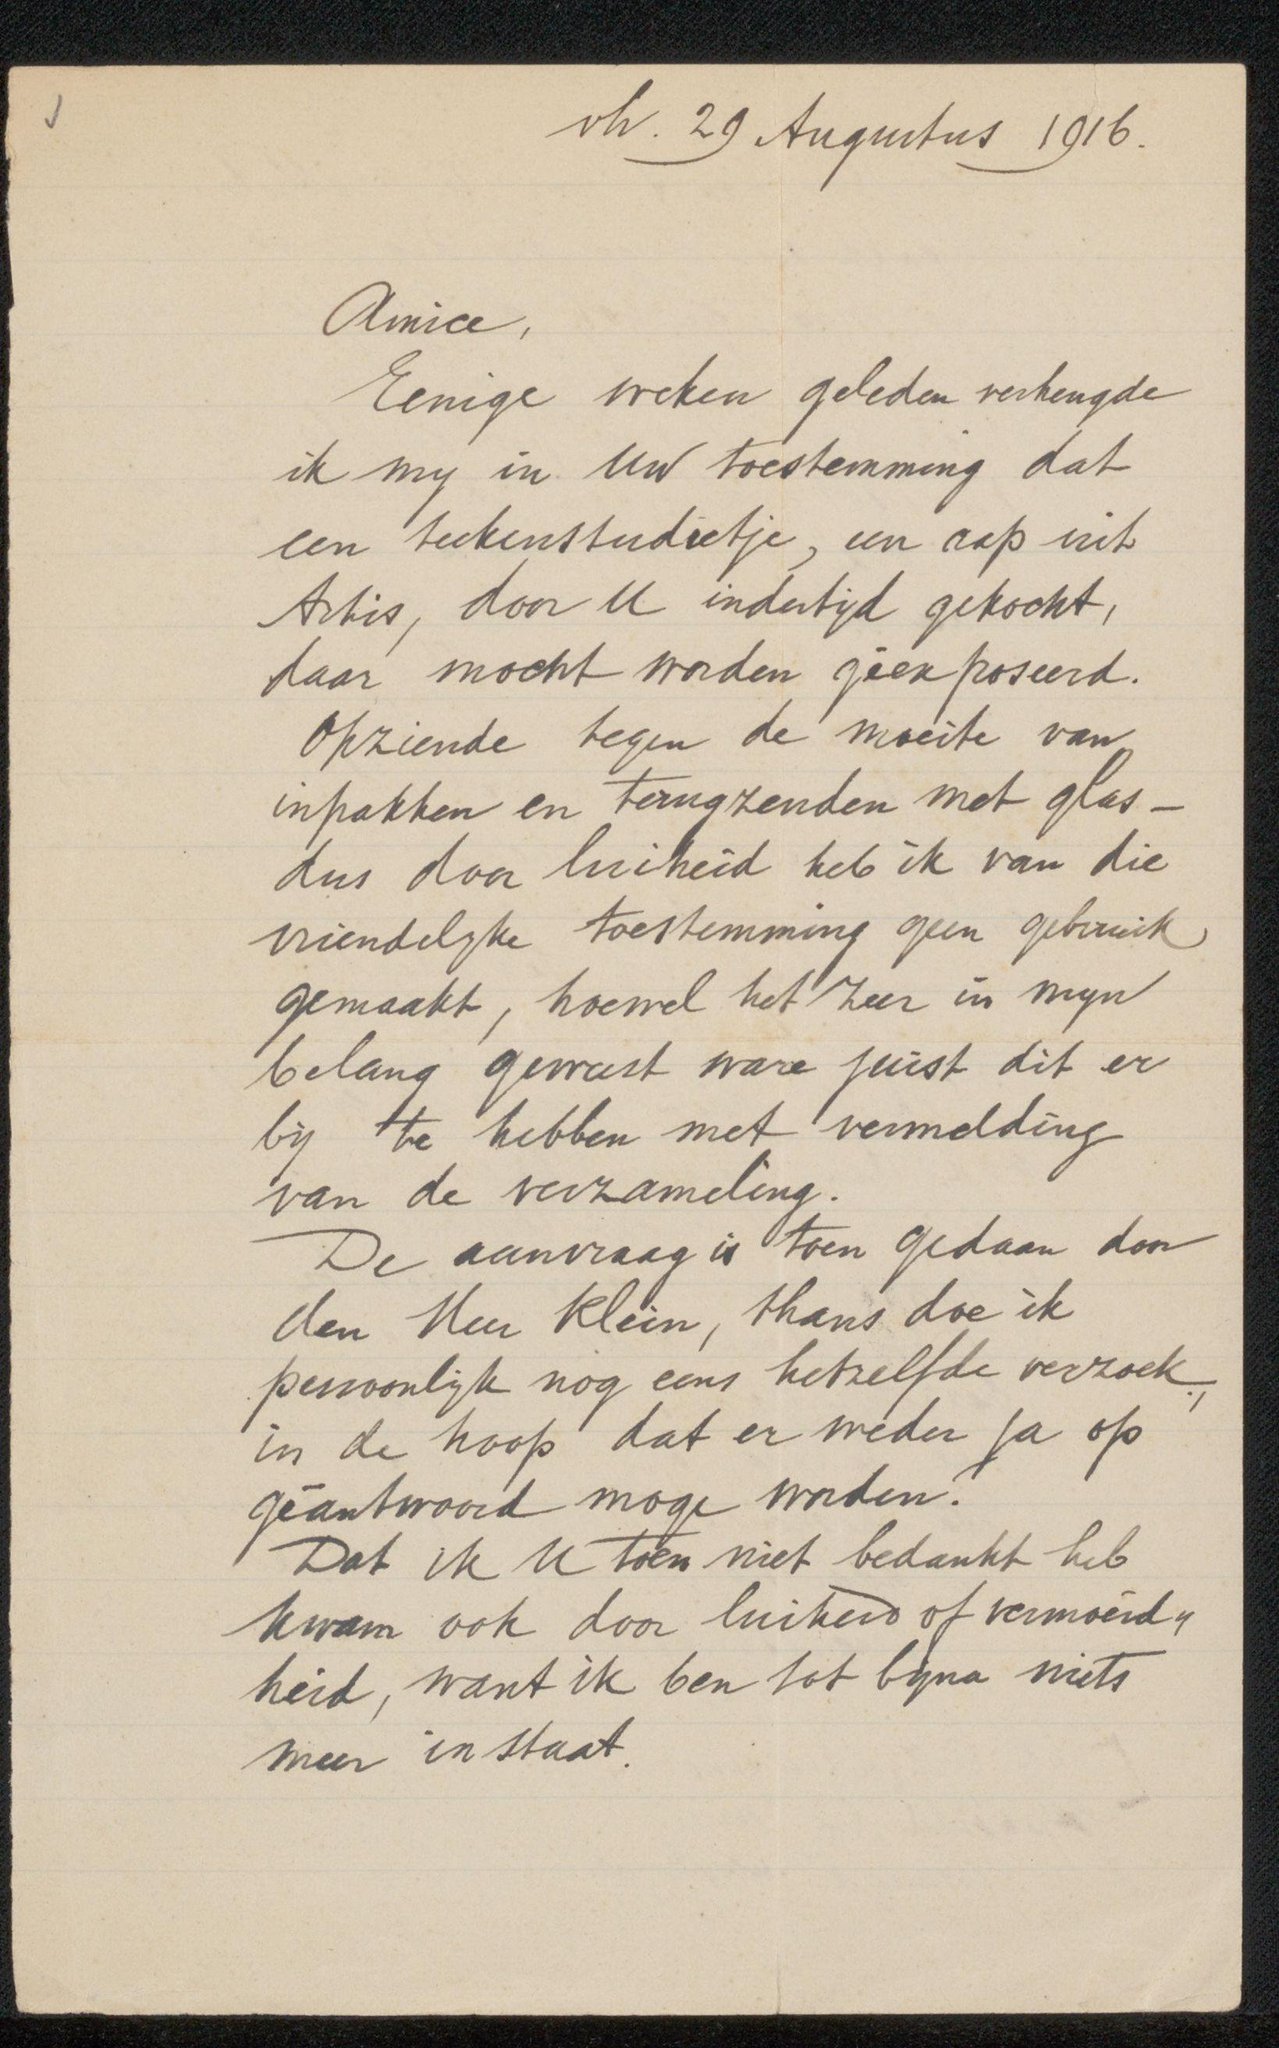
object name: letter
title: Brief aan Jan Veth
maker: august allebé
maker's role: draughtsman, print maker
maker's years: 1838-1927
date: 1916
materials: ink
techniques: pen, writing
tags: dordrecht, designer, jan veth, leiden, amsterdam, painter, print maker, draughtsman, rembrandt van rijn, käthe kollwitz, drawing, exhibition ~ art, art collecting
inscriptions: collector's mark: ‘RPK’